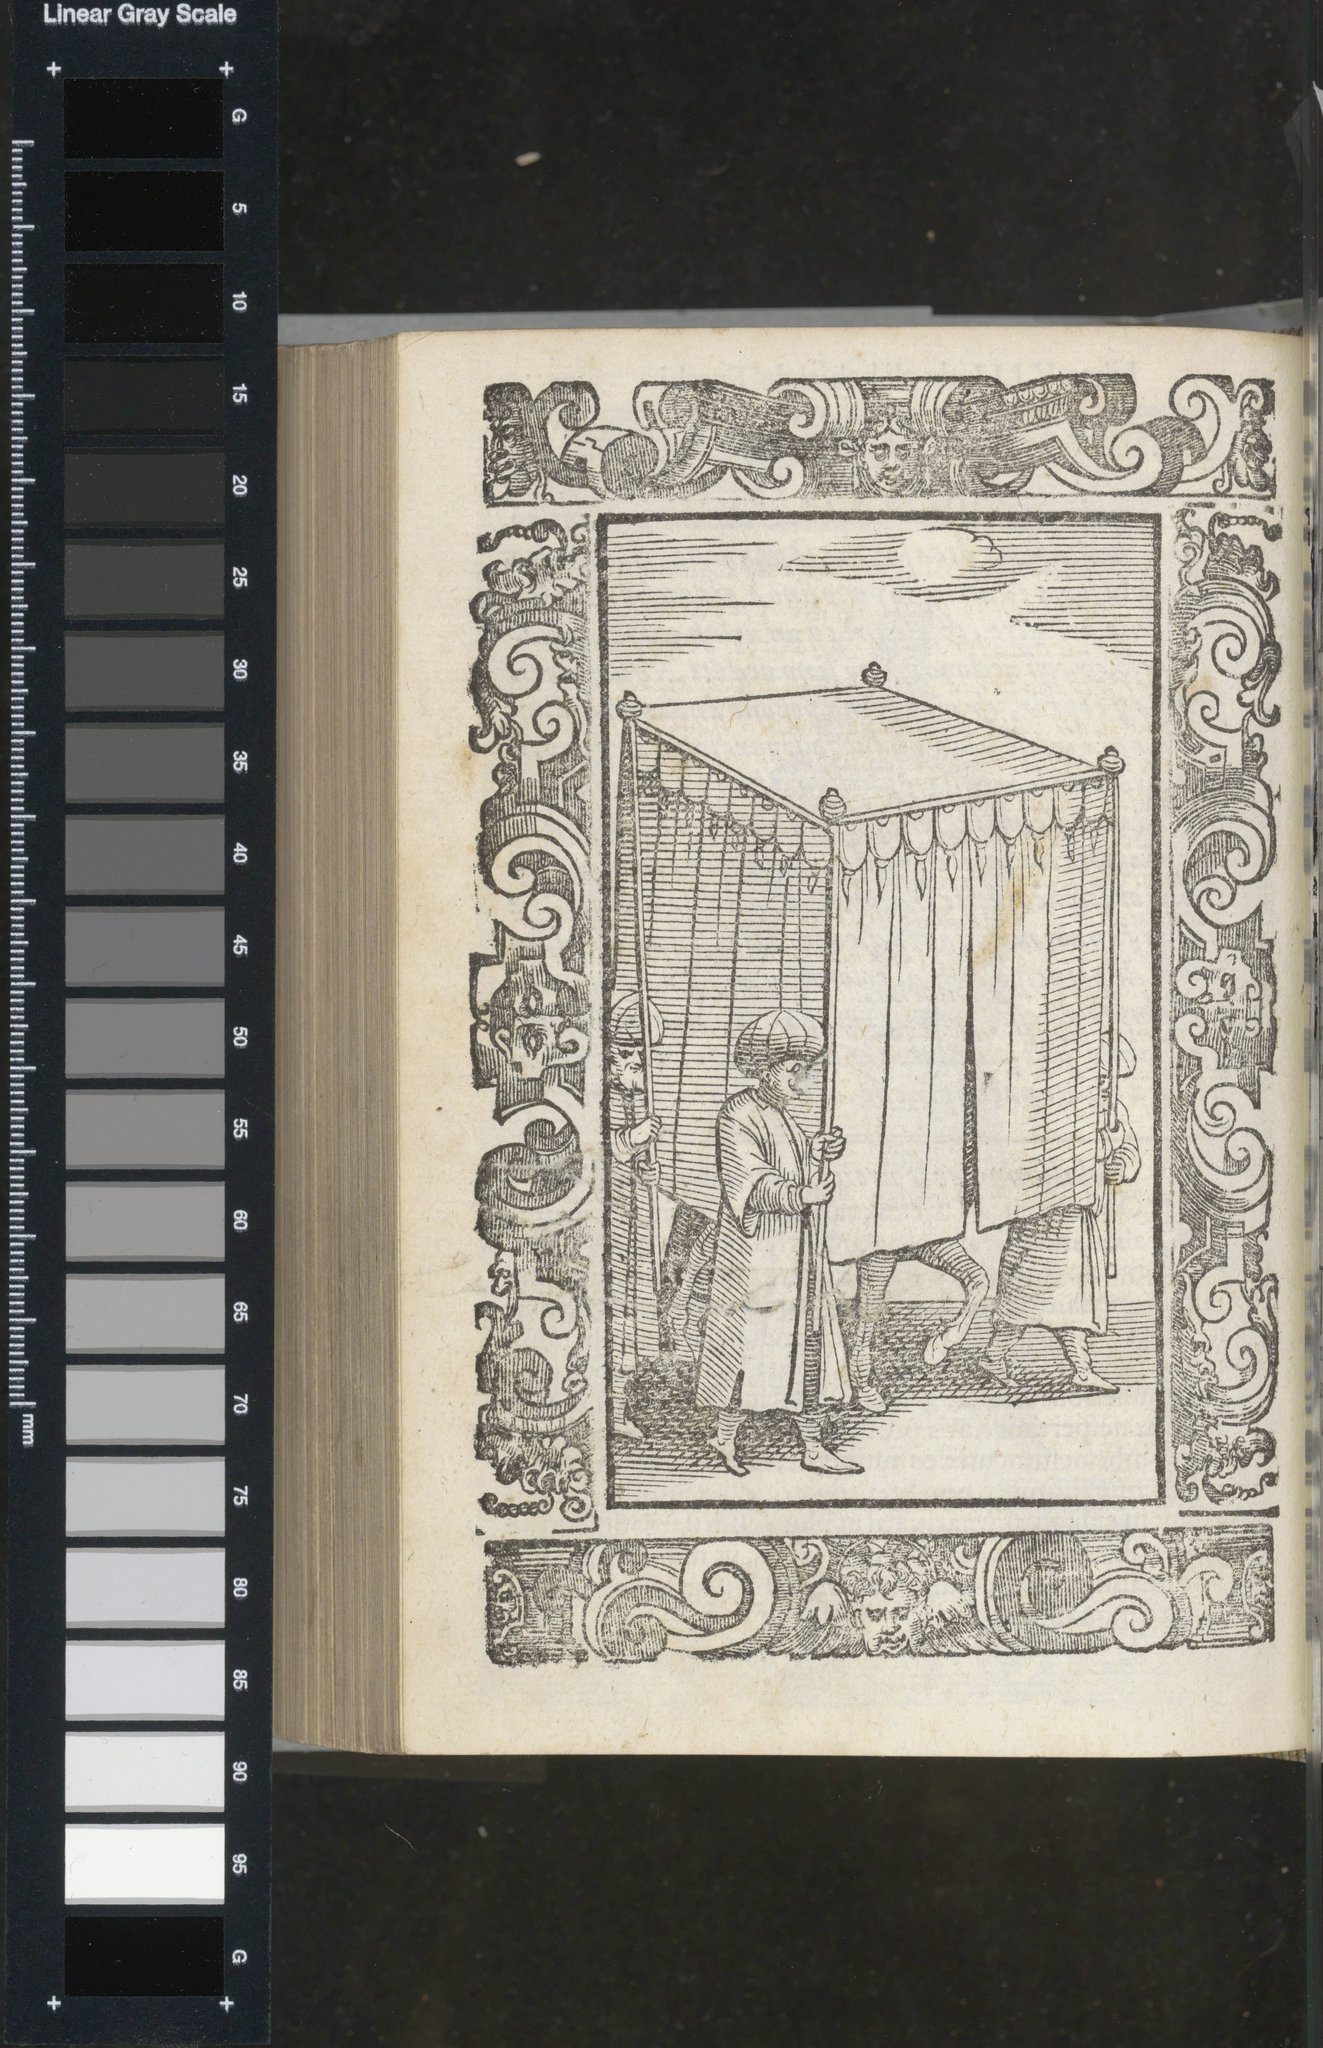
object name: costume print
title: Habiti antichi, et moderni di tutto il mondo...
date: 1598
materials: paper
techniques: woodcut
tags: riding a horse, ass, or mule; rider, horseman, canopy, baldachin, asiatic races and peoples: turks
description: Een (onzichtbare) Turkse vrouw rijdt op een paard. Om haar heen lopen vier Turkse mannen die een baldakijn ophouden zodat ze onzichtbaar is voor mannenblikken.